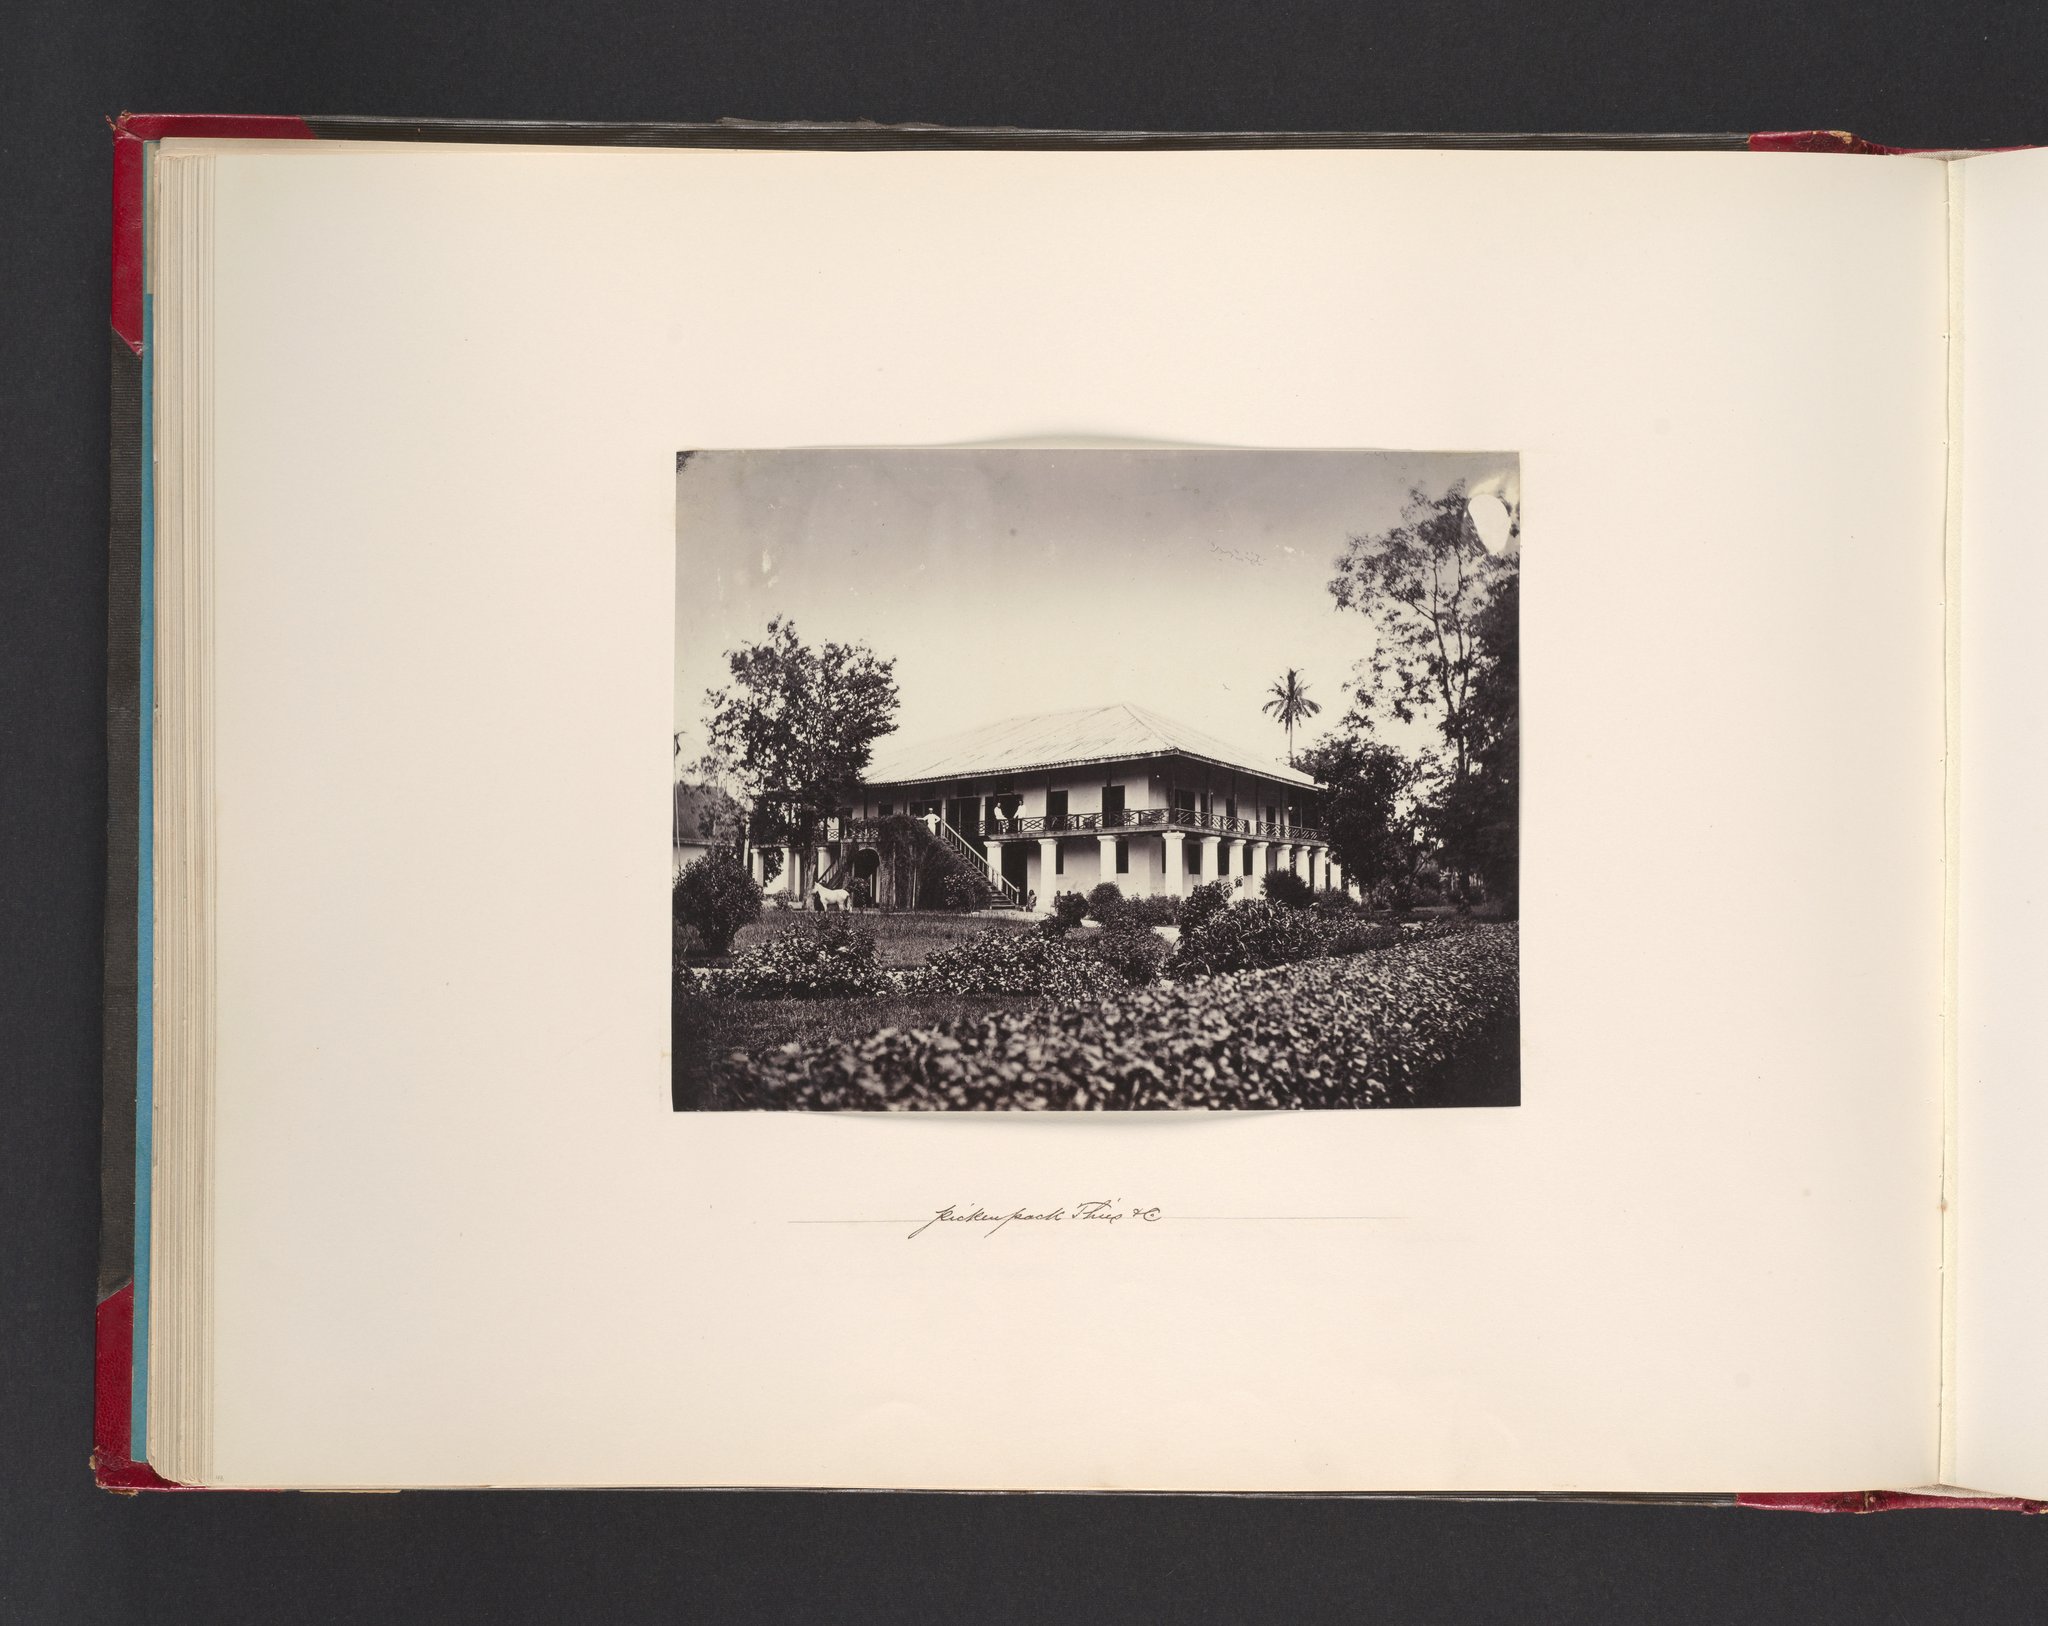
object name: photograph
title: Pickenpack Thies & Co.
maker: john thomson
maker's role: artist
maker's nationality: british, scottish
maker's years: 1837-1921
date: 1865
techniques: albumen silver print, glass negative